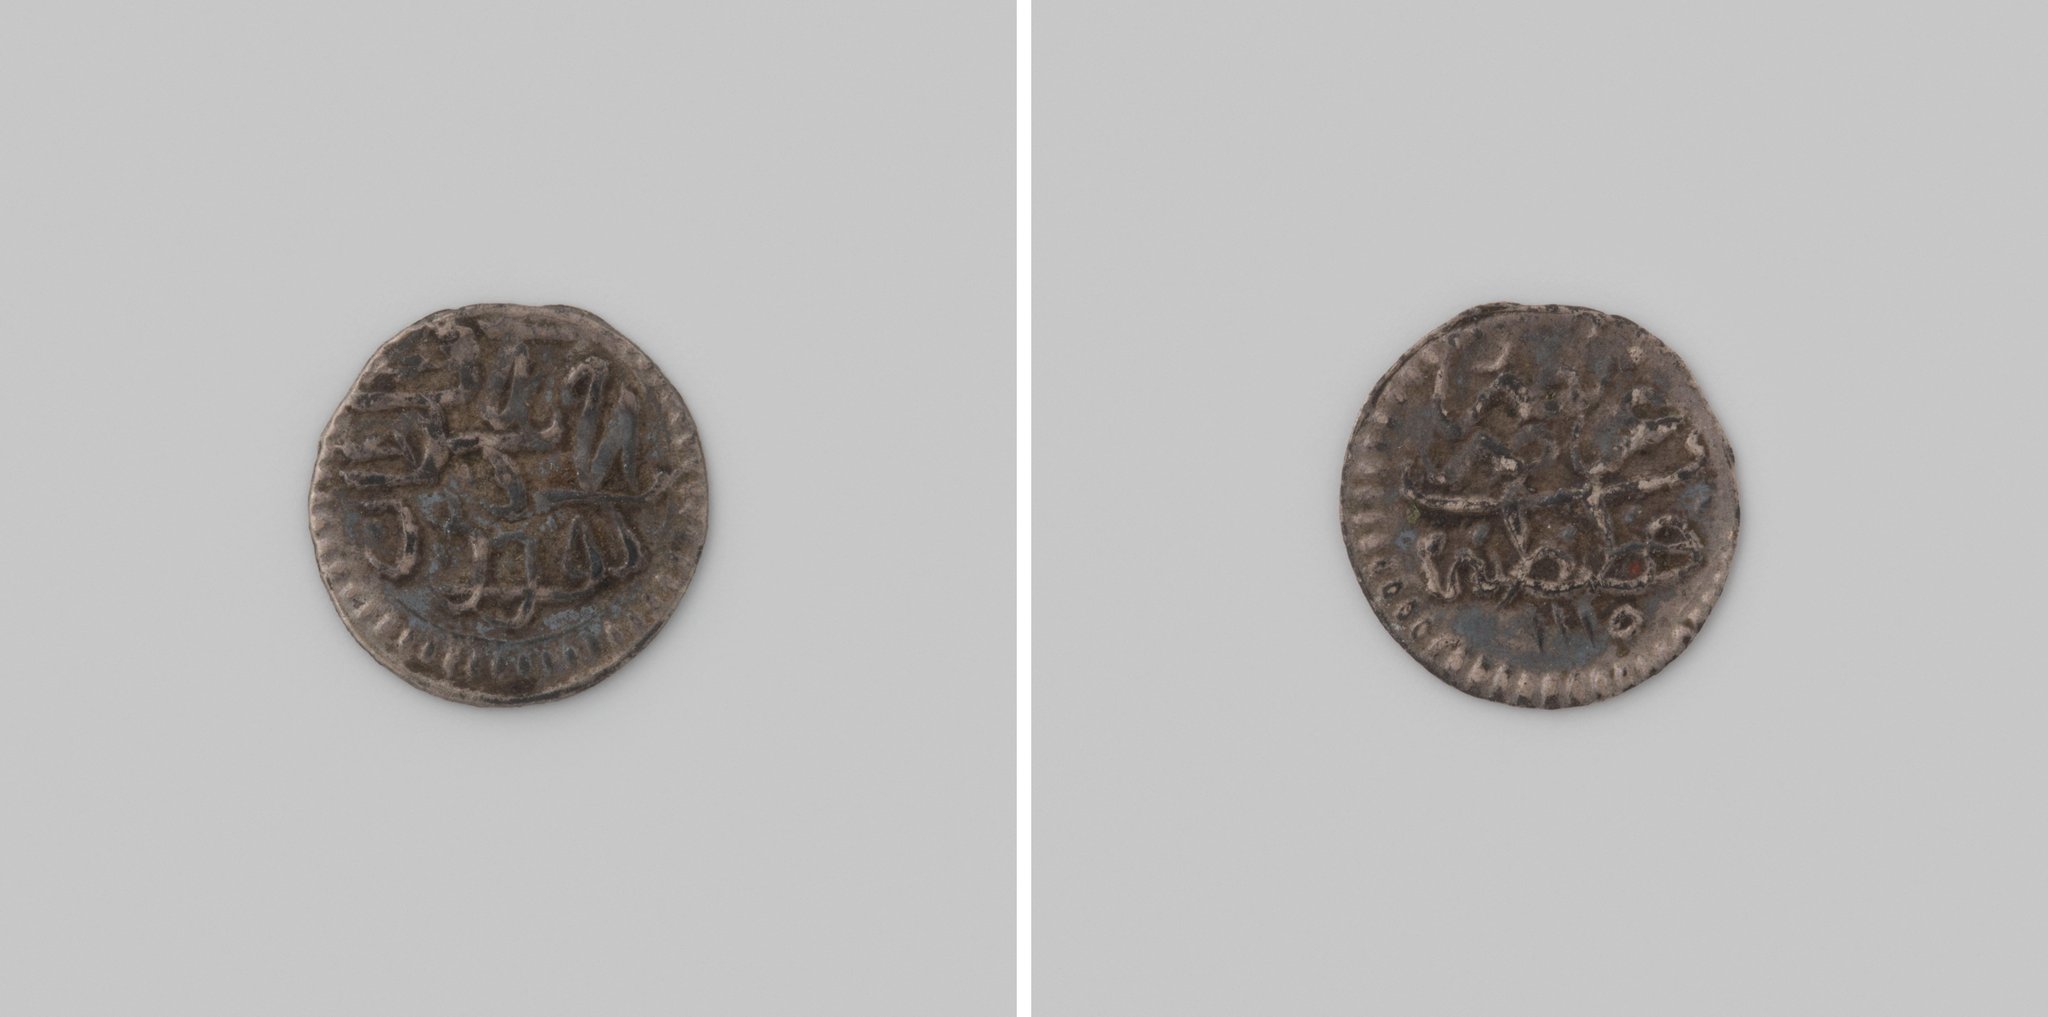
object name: coin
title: Akce uit Turkije van sultan Ahmed III, 1115-1143 [=1703-1730]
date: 1703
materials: silver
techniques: striking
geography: constantinople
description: Zilveren munt. Voorzijde: drieregelig opschrift in Arabische letters. Keerzijde: drieregelig opschrift in Arabische letters, met muntplaats-aanduiding: Constantinopel. Daaronder jaartal:1115